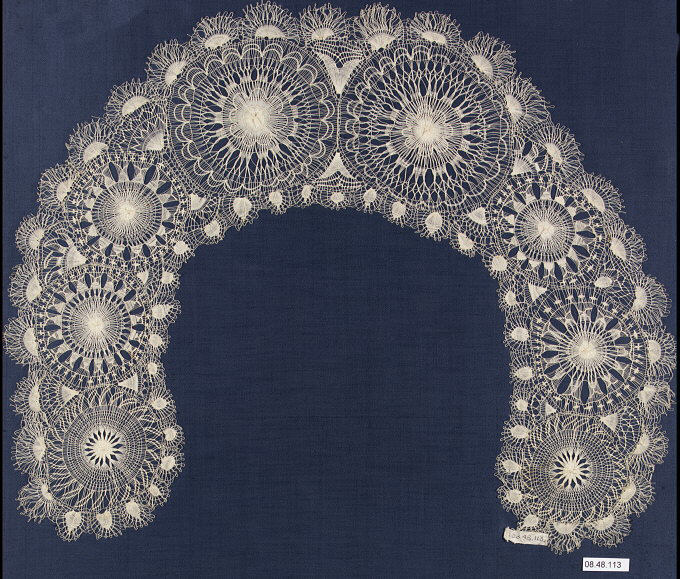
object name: collar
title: Lace collar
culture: paraguayan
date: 1801-1900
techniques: embroidery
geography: paraguay